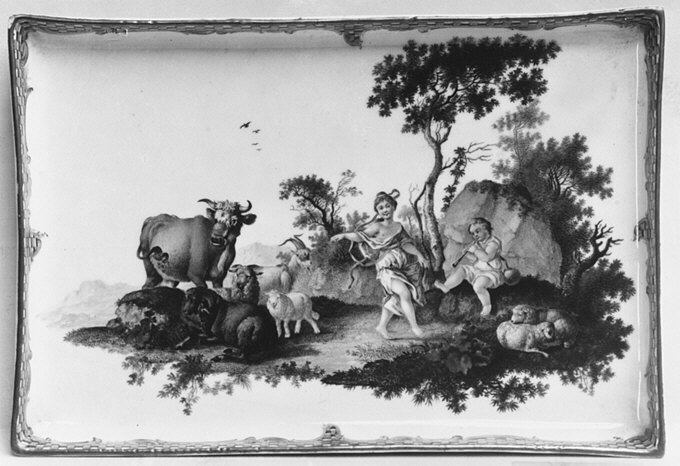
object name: tray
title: Tray (part of a set)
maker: meissen manufactory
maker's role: manufactory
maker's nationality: german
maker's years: 1710-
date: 1765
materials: hard paste porcelain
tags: girls,bulls,sheep,trees